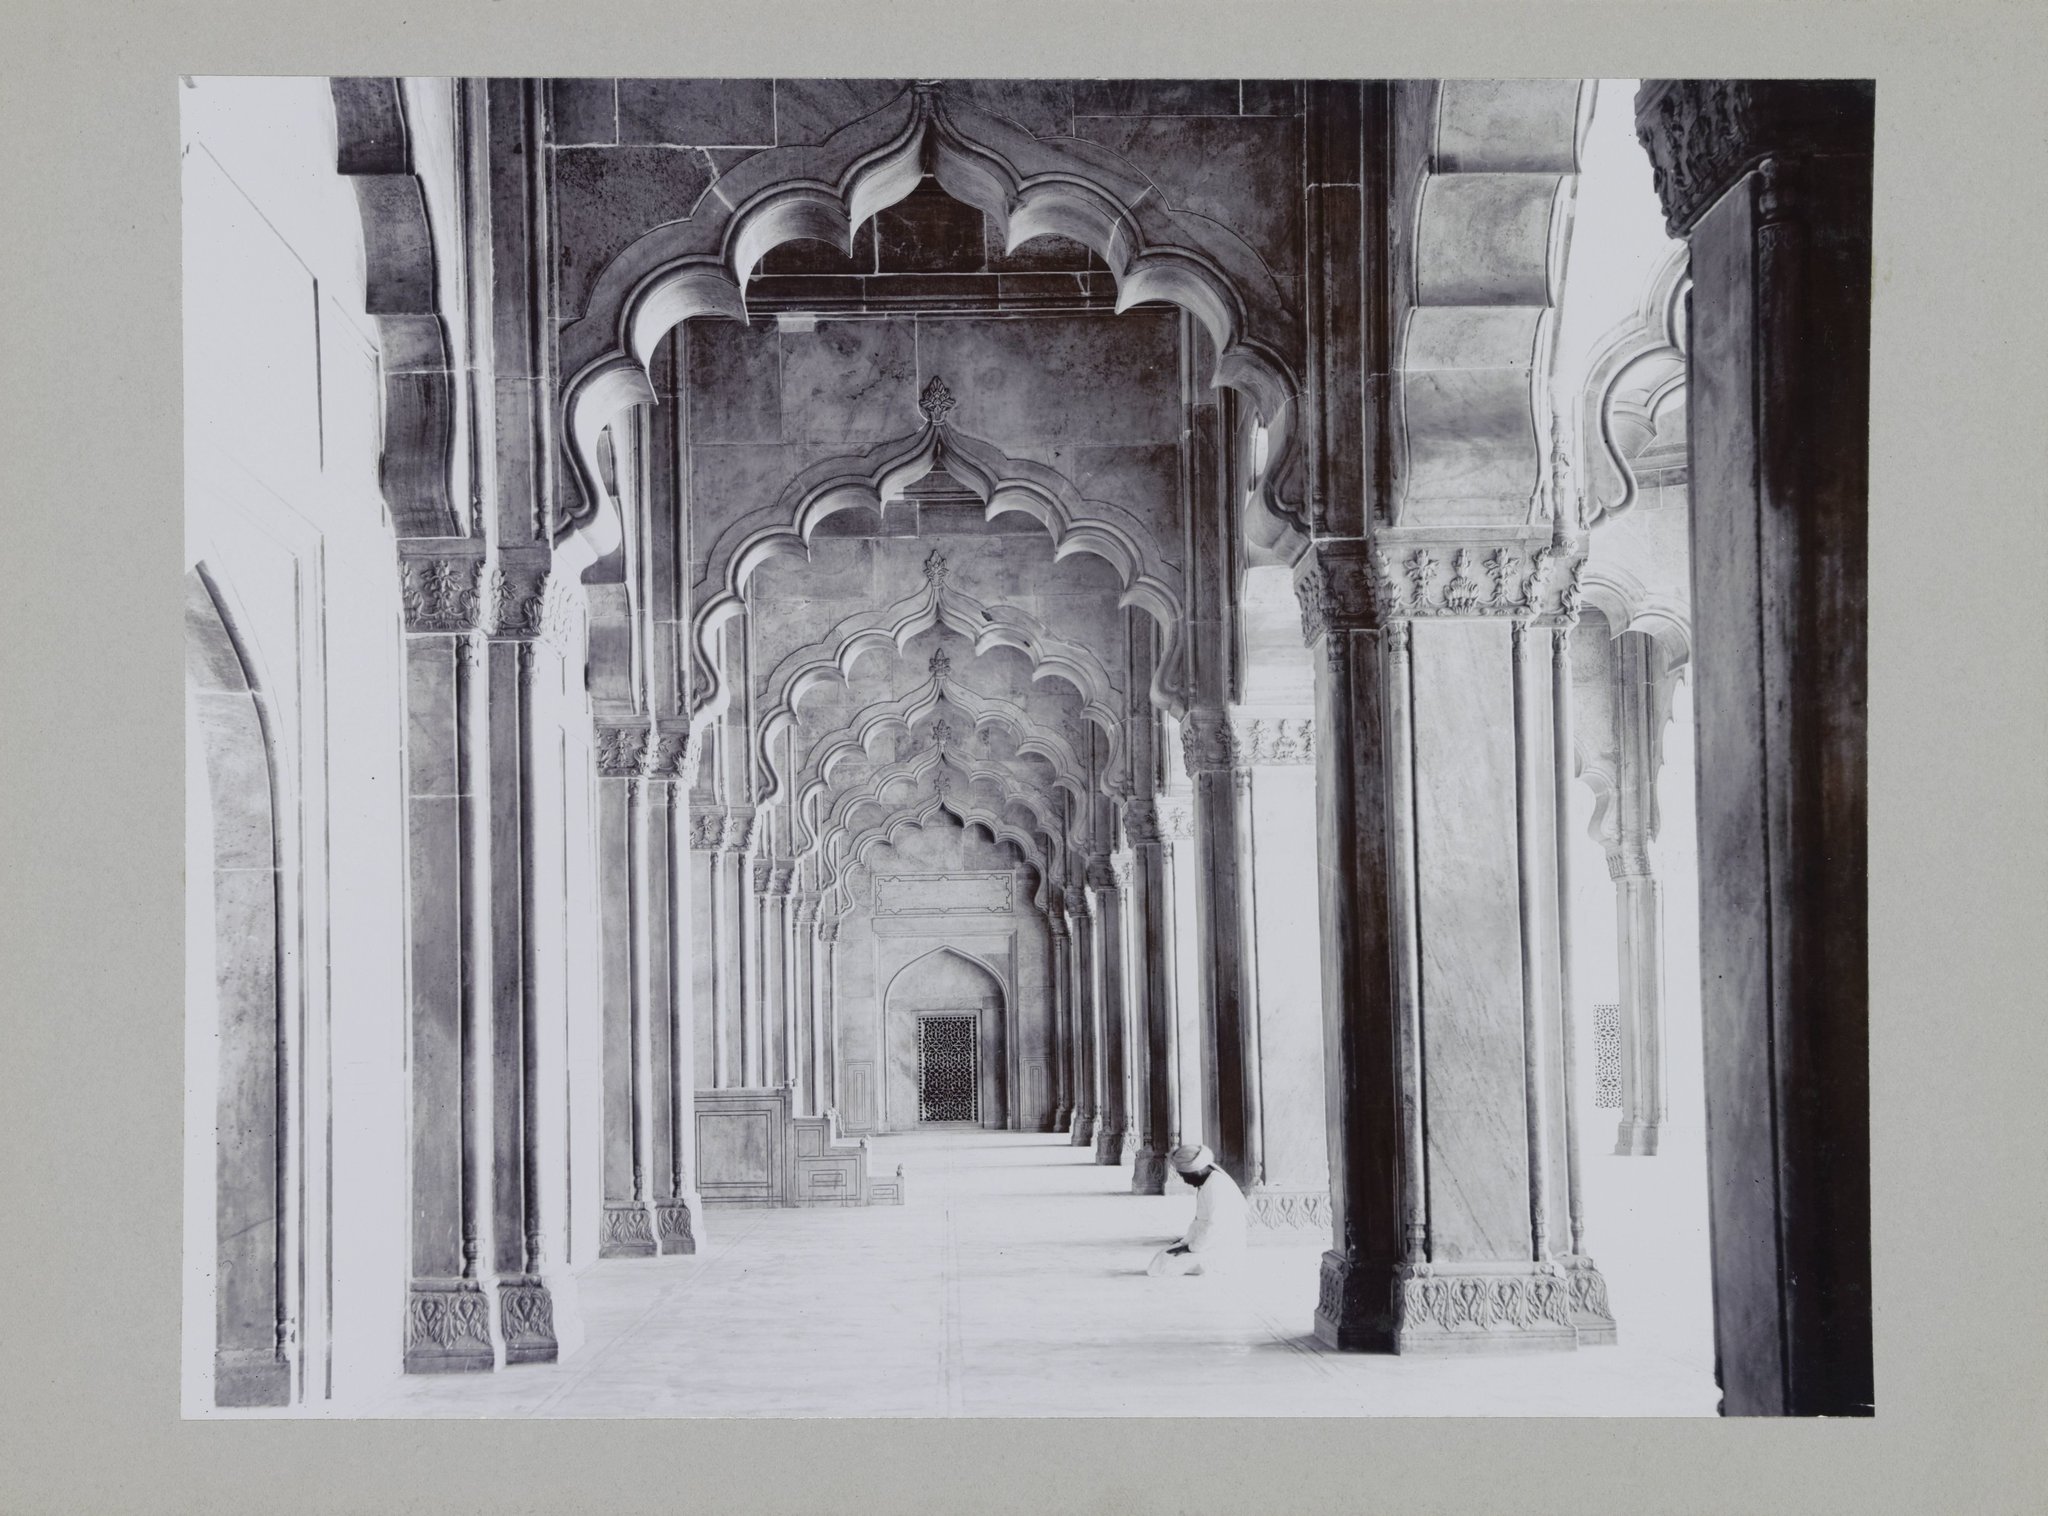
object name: photograph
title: Mosque inside the Agra Fort, Uttar Pradesh, India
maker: Anonymous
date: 1895-1915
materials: cardboard, paper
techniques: gelatin silver print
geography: agra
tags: agra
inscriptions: annotation: ‘61. Moskee i/'t fort te Agra.’